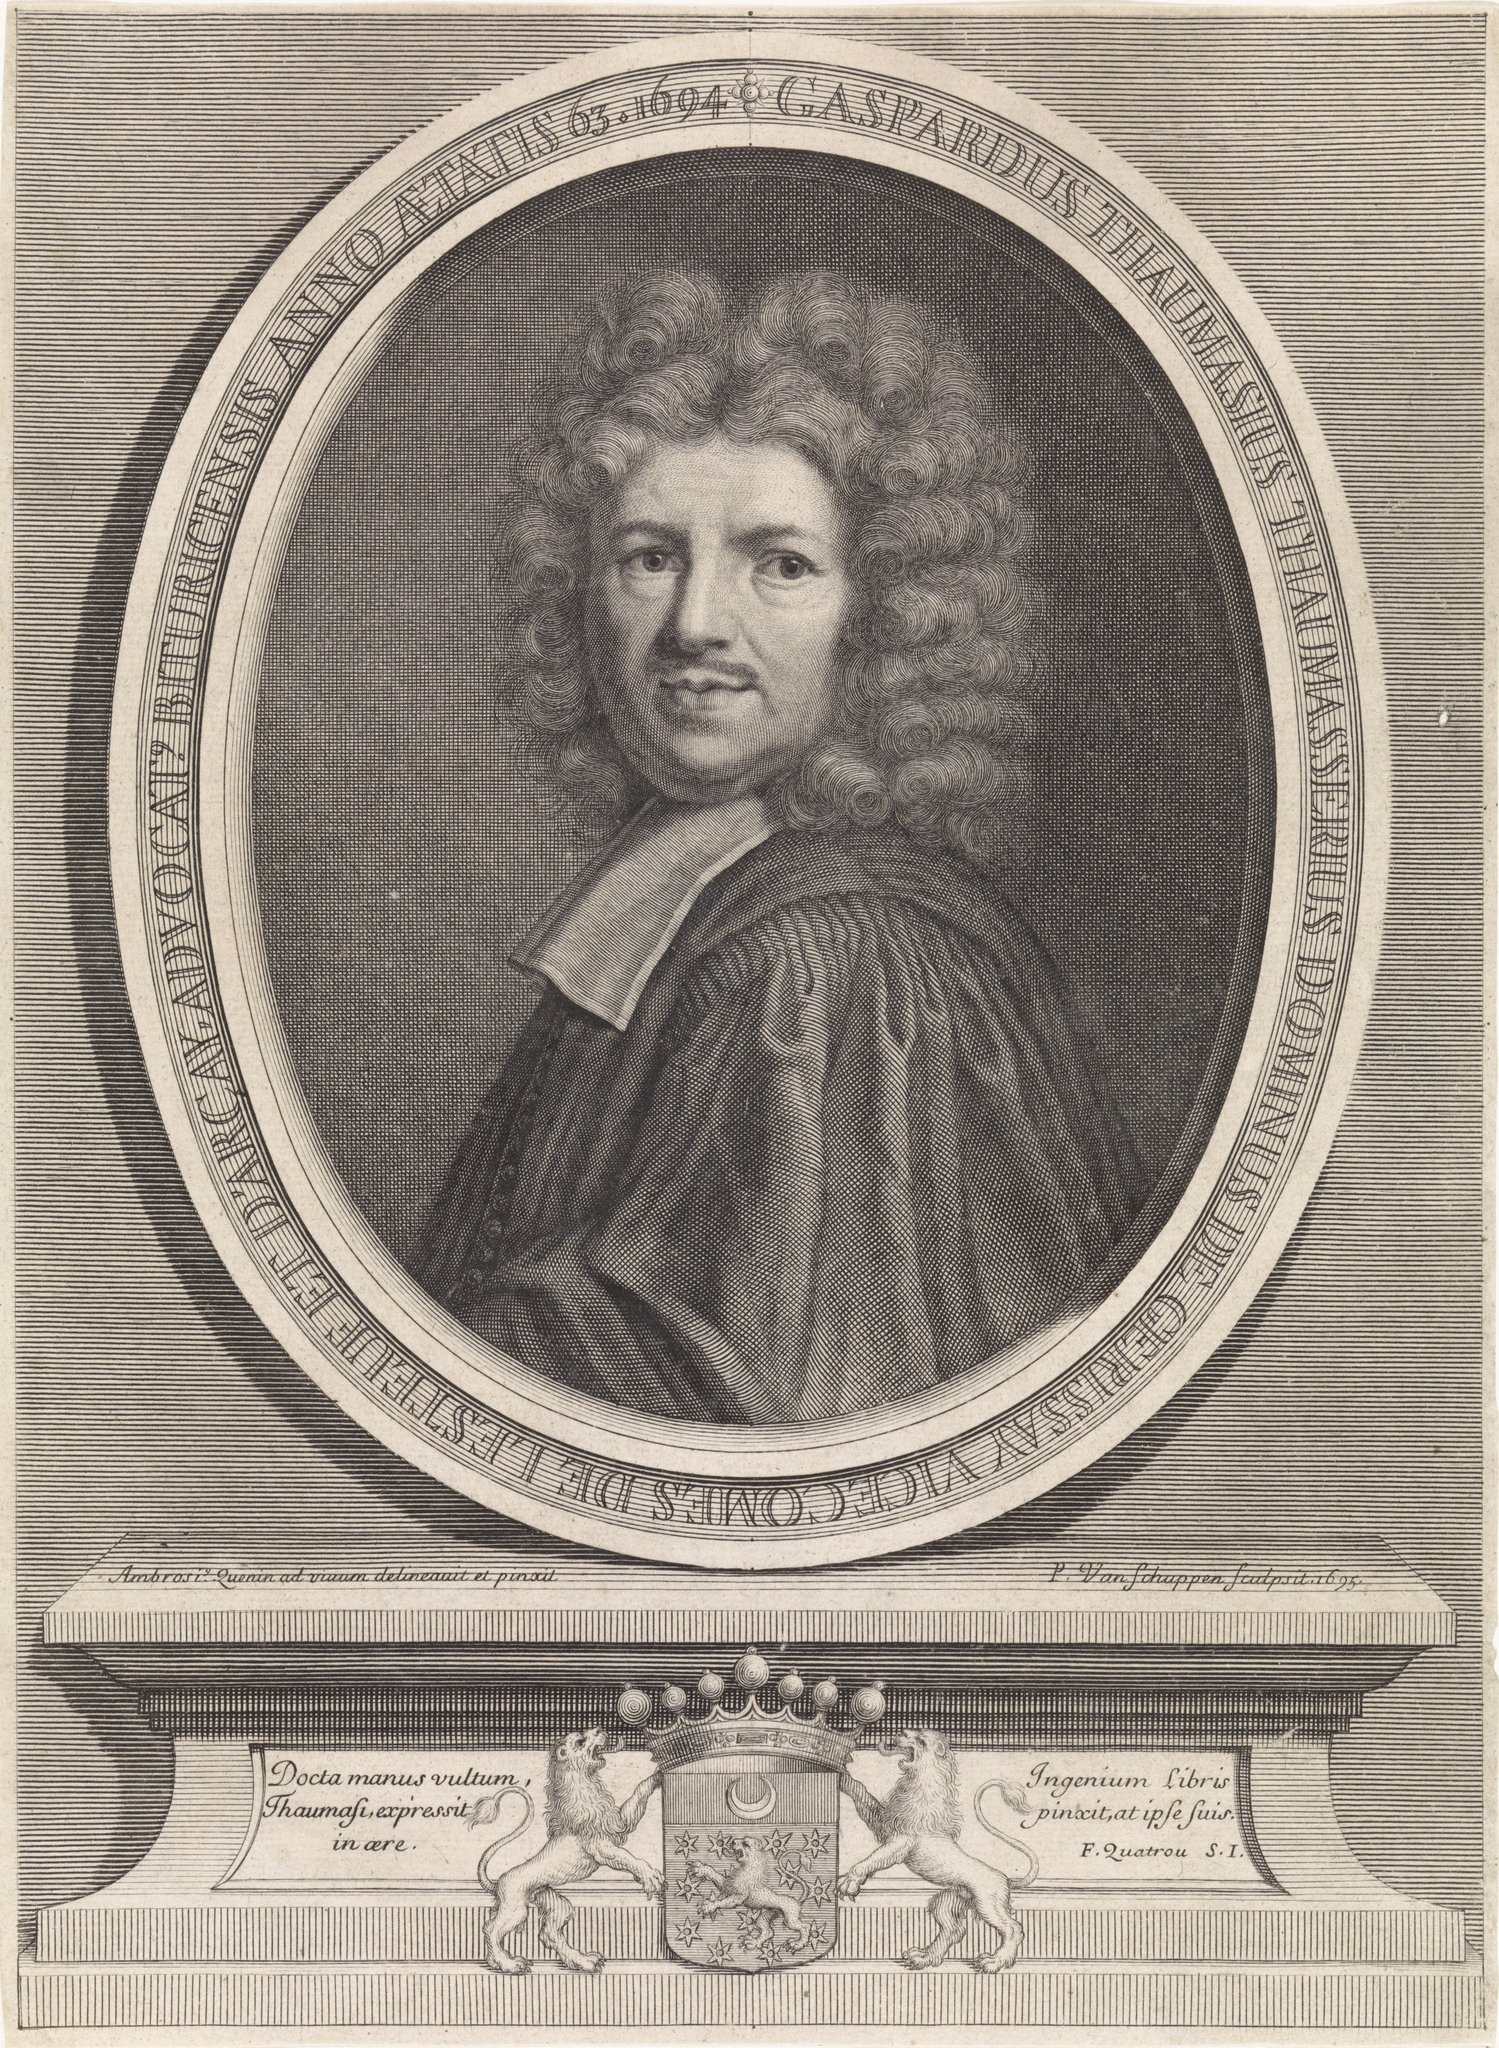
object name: print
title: Portret van de jurist Gaspard Thaumas de la Thaumasière, heer van Gerissay op 63-jarige leeftijd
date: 1605-1695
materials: paper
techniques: engraving, etching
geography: paris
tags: jurist, gaspard thaumas de la thaumasière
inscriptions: collector's mark: Lugt 2228